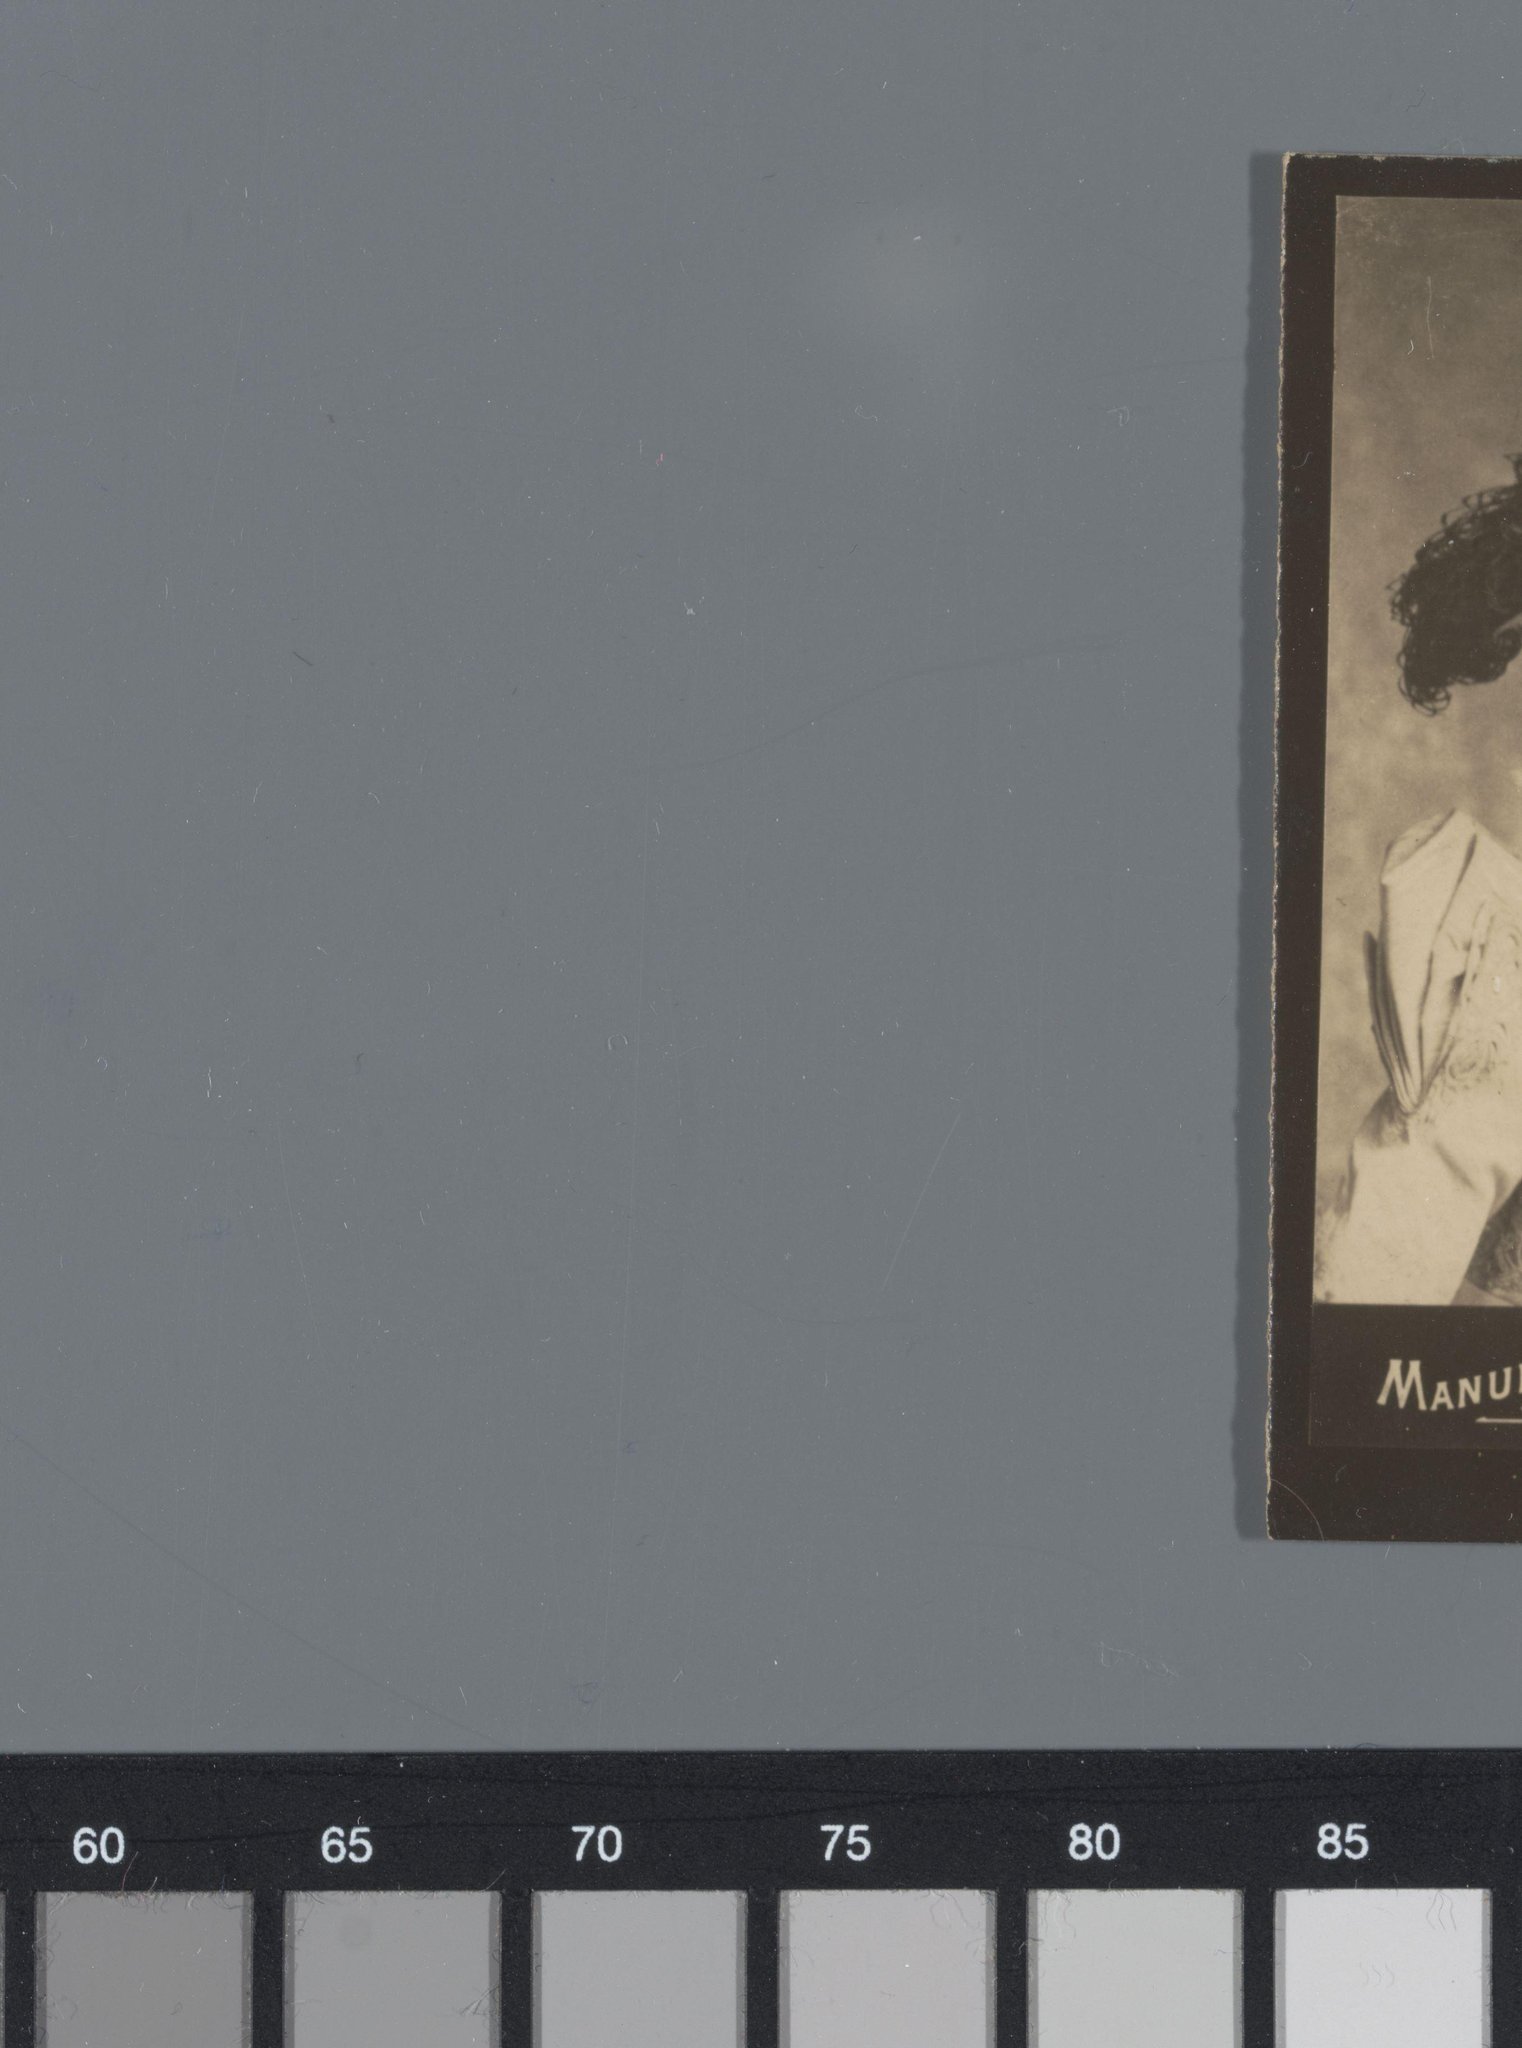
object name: photograph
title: May Derrickson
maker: Anonymous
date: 1895-1910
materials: paper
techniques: gelatin silver print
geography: united states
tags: adult woman, historical persons, united states of america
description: Dergelijke foto's stonden bekend als 'zwartjes'. Men verkreeg ze bij aanschaf van bepaalde merken thee, cacao, sigaretten, beschuit, etc. om te verzamelen. Er waren speciaal voor de 'zwartjes' verzamelalbums in omloop.